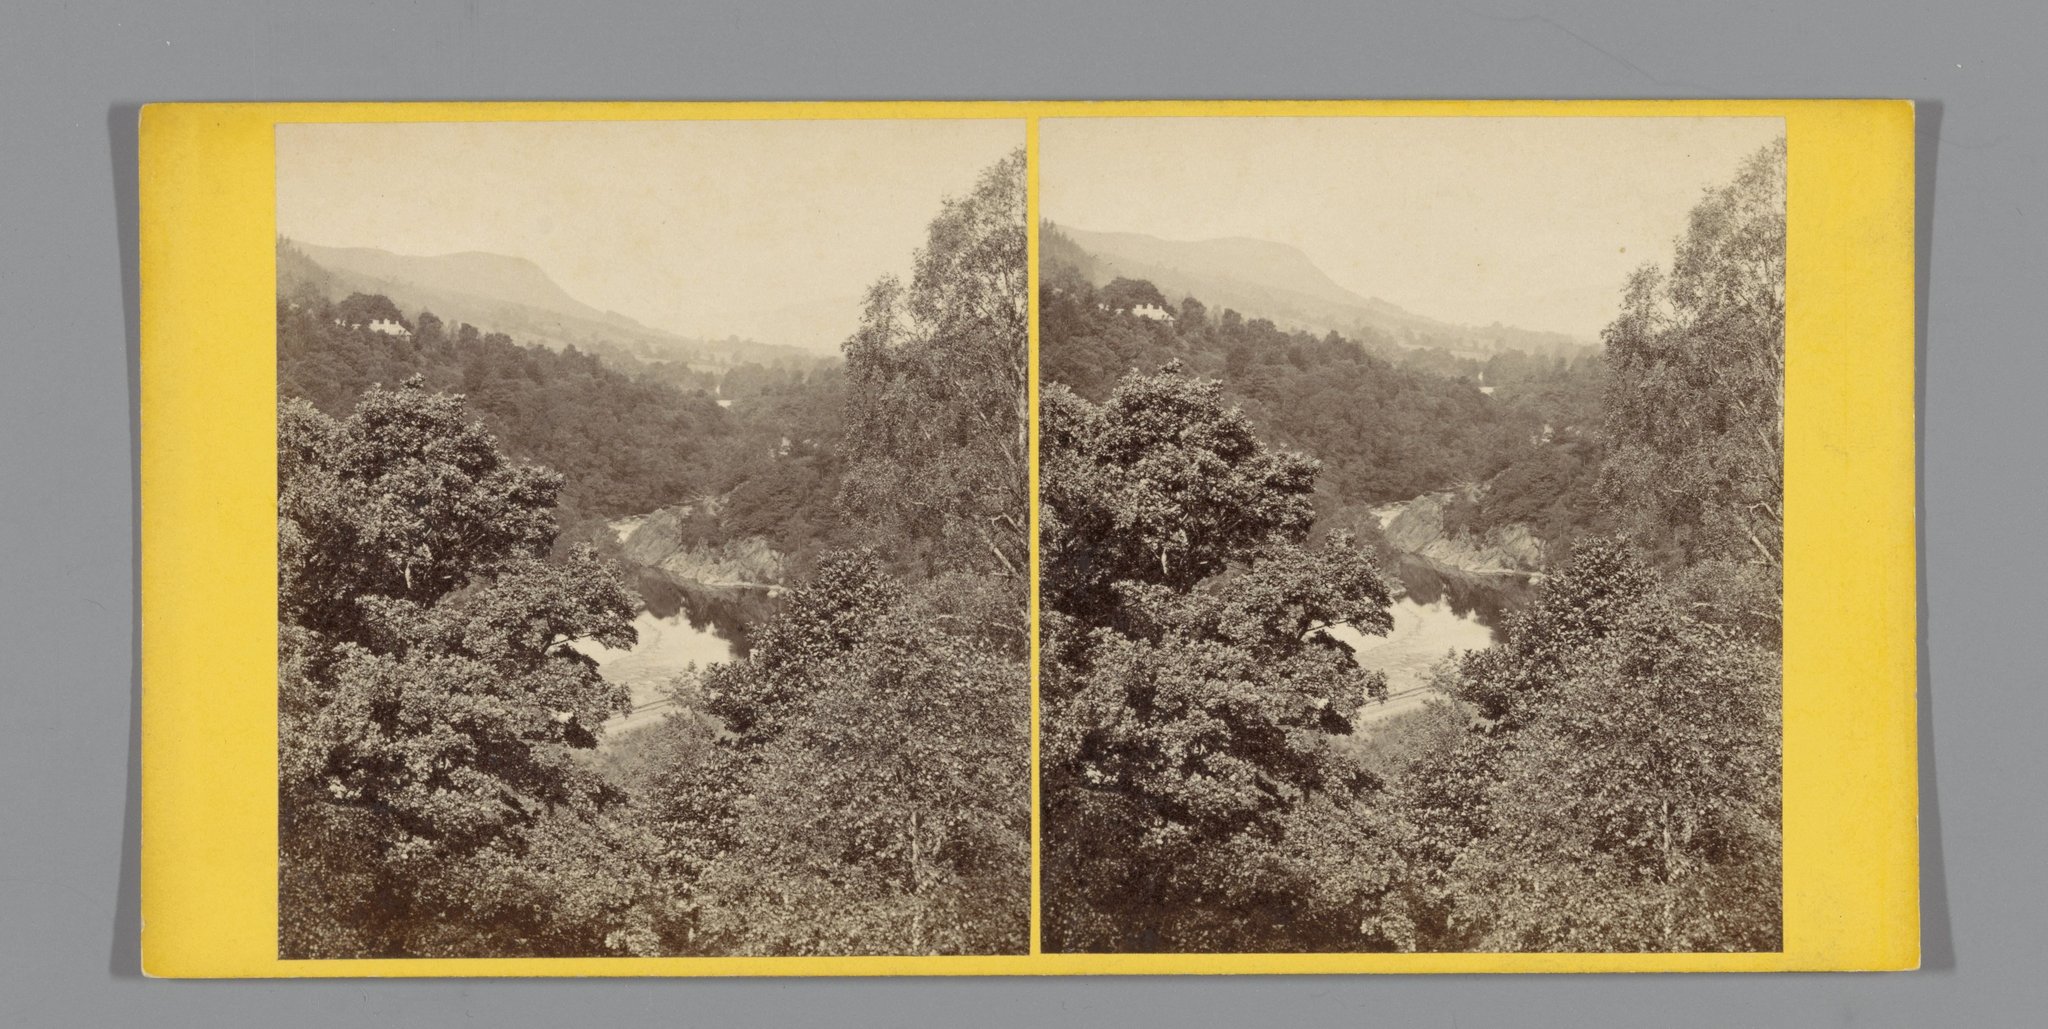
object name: stereograph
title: Pass of Killiecrankie, looking up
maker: george washington wilson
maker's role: publisher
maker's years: 1823-1893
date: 1850-1880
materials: cardboard, photographic support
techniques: albumen print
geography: killiecrankie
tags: dale, valley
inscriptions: name: ‘Registered G. W. Wilson, Photographer, Aberdeen.’, number: ‘No. 473.’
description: Het object RP-F-F04834 is vermoedelijk tijdens dezelfde fotografeersessie gemaakt.